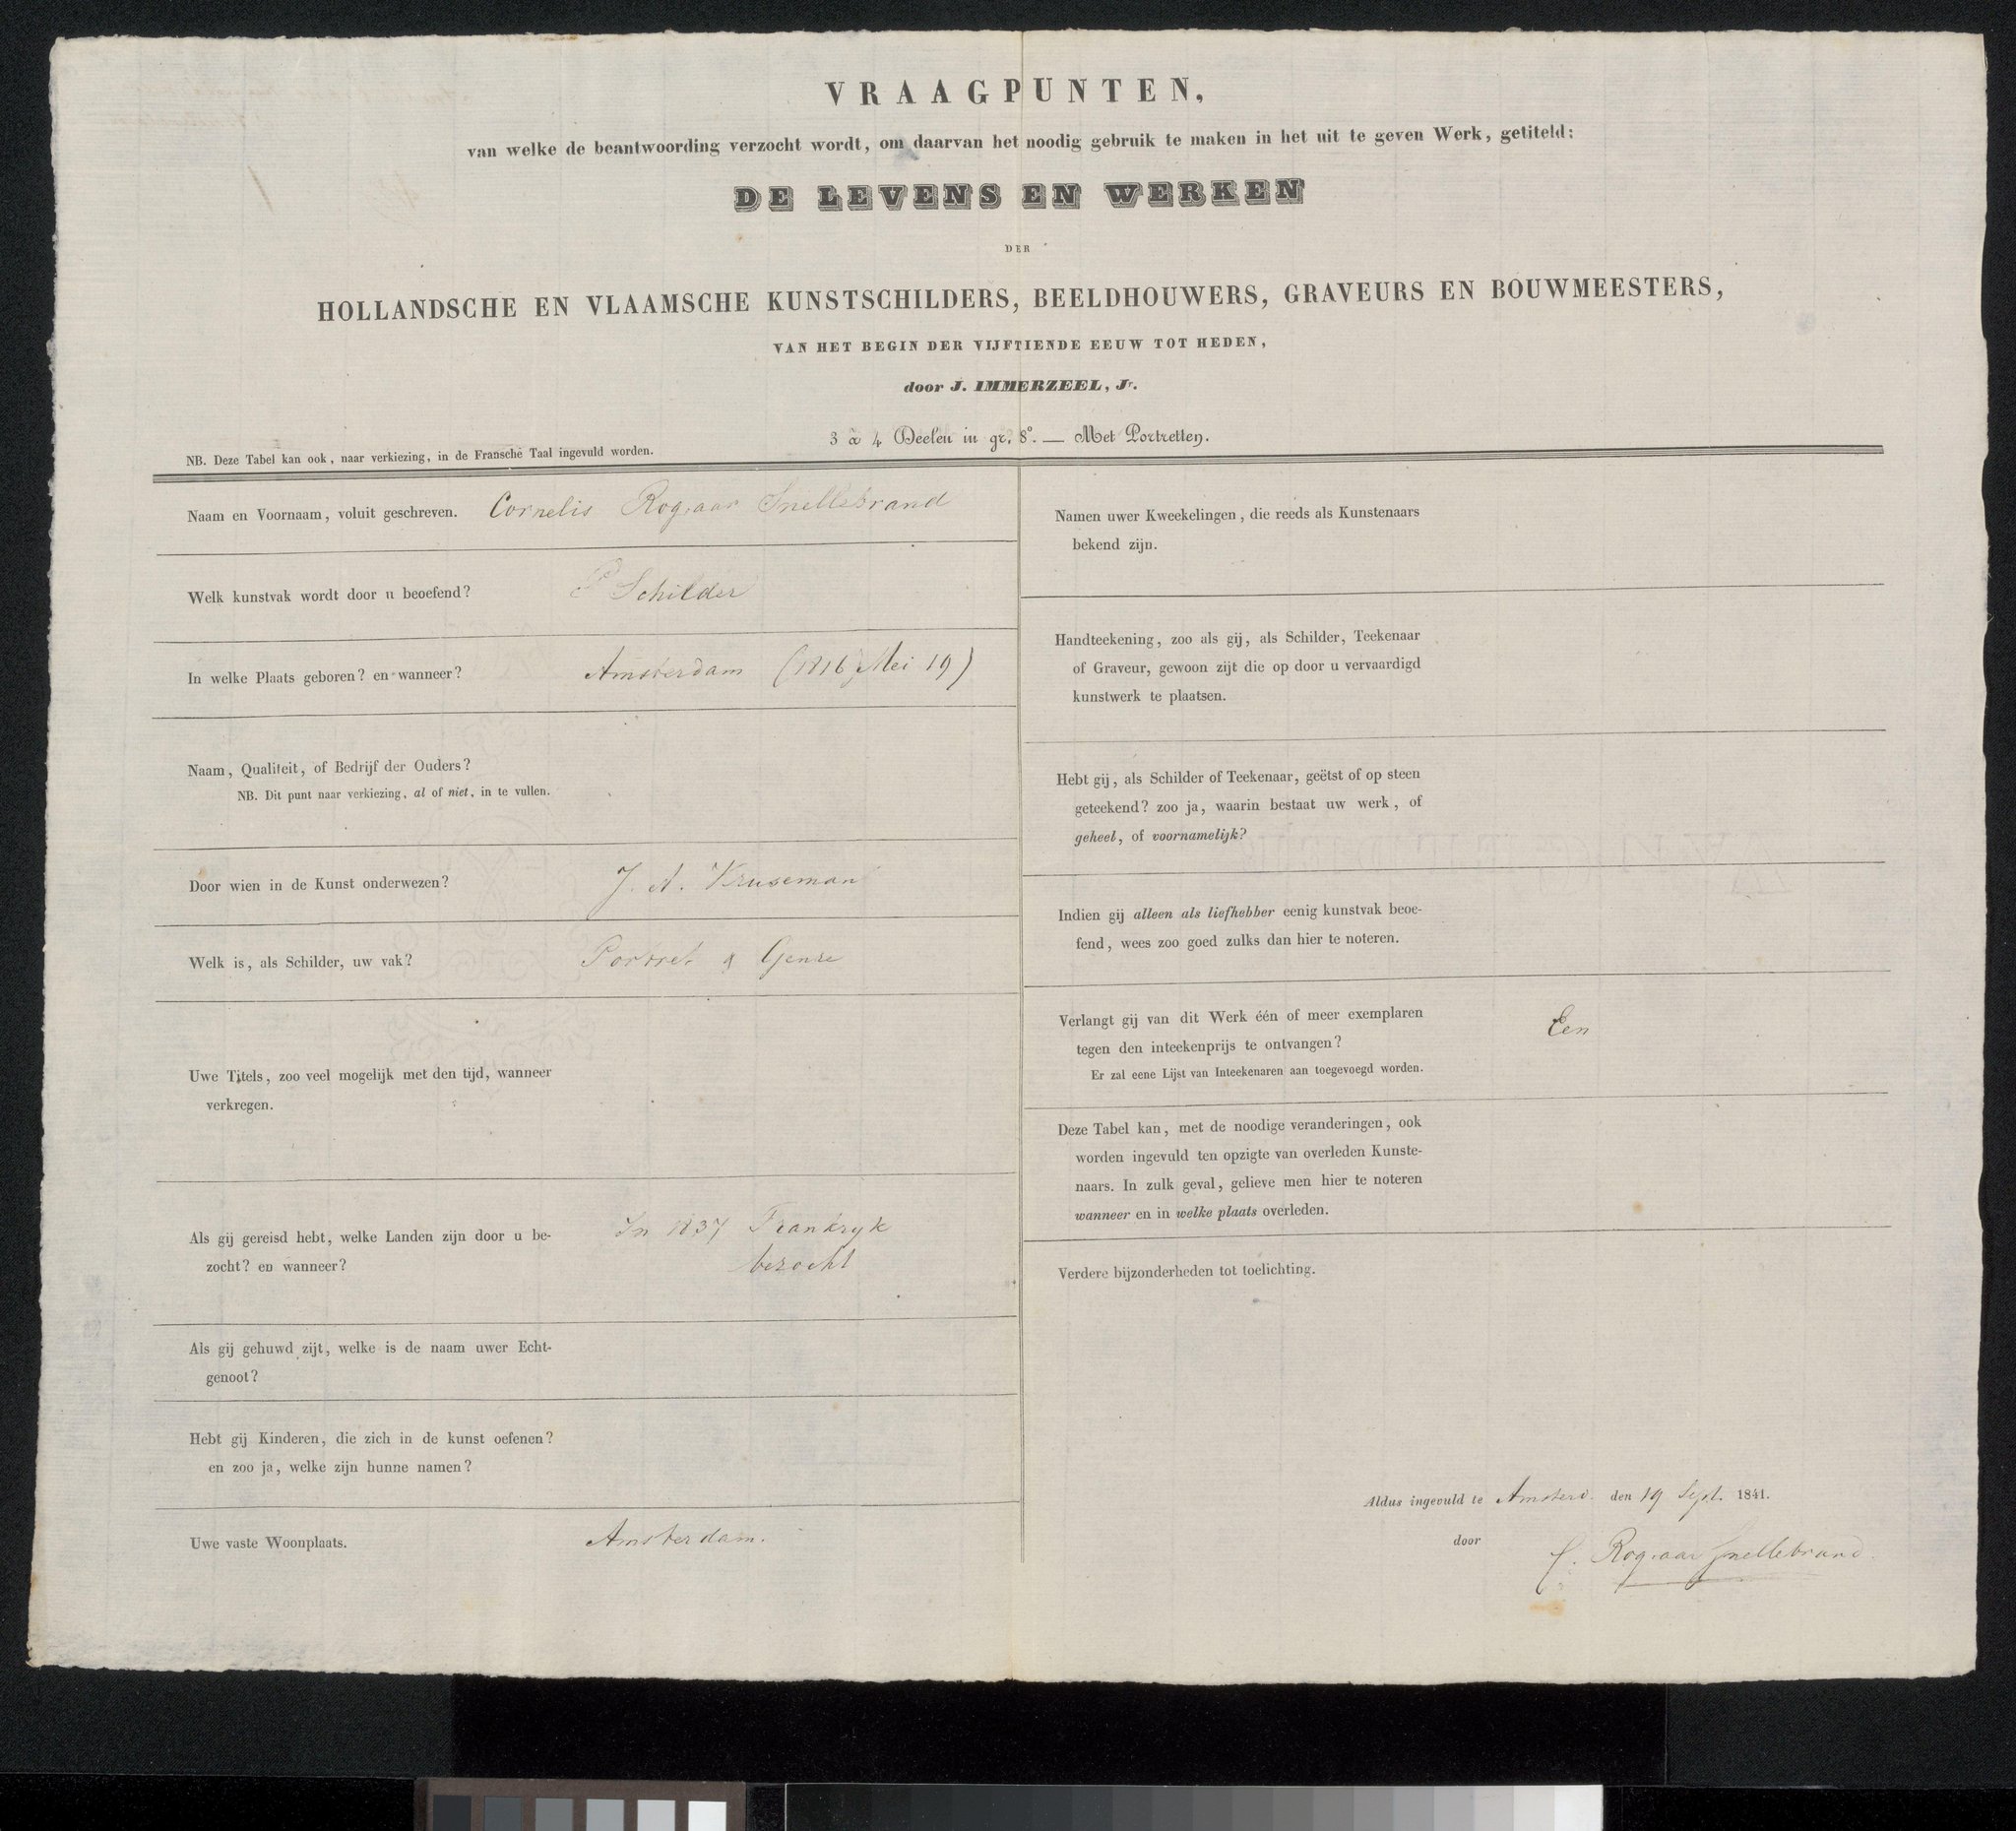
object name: questionnaire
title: Enquêteformulier ingevuld door Cornelis Rogaar Snellebrand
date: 1841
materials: ink, paper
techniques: pen, printing, writing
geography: amsterdam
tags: amsterdam, painter, draughtsman, cornelis rogaar snellebrand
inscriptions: inscription: ‘Vraagpunten,/ van welke de beantwoording verzocht wordt, om daarvan het noodig gebruik te maken in het uit te geven Werk, getiteld: De levens en werken/ der Hollandsche en Vlaamsche kunstschilders, beeldhouwers,/ graveurs en bouwmeesters, van het begin der vijftiende eeuw tot heden/ door J. Immerzeel, Jr.’, watermark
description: Bedoeld voor: Immerzeel, J. Jr., De levens en werken der Hollandsche en Vlaamsche kunstschilders, beeldhouwers, graveurs en bouwmeesters, van het begin der vijftiende eeuw tot heden, Amsterdam: J.C. van Kesteren, 1842-1843.